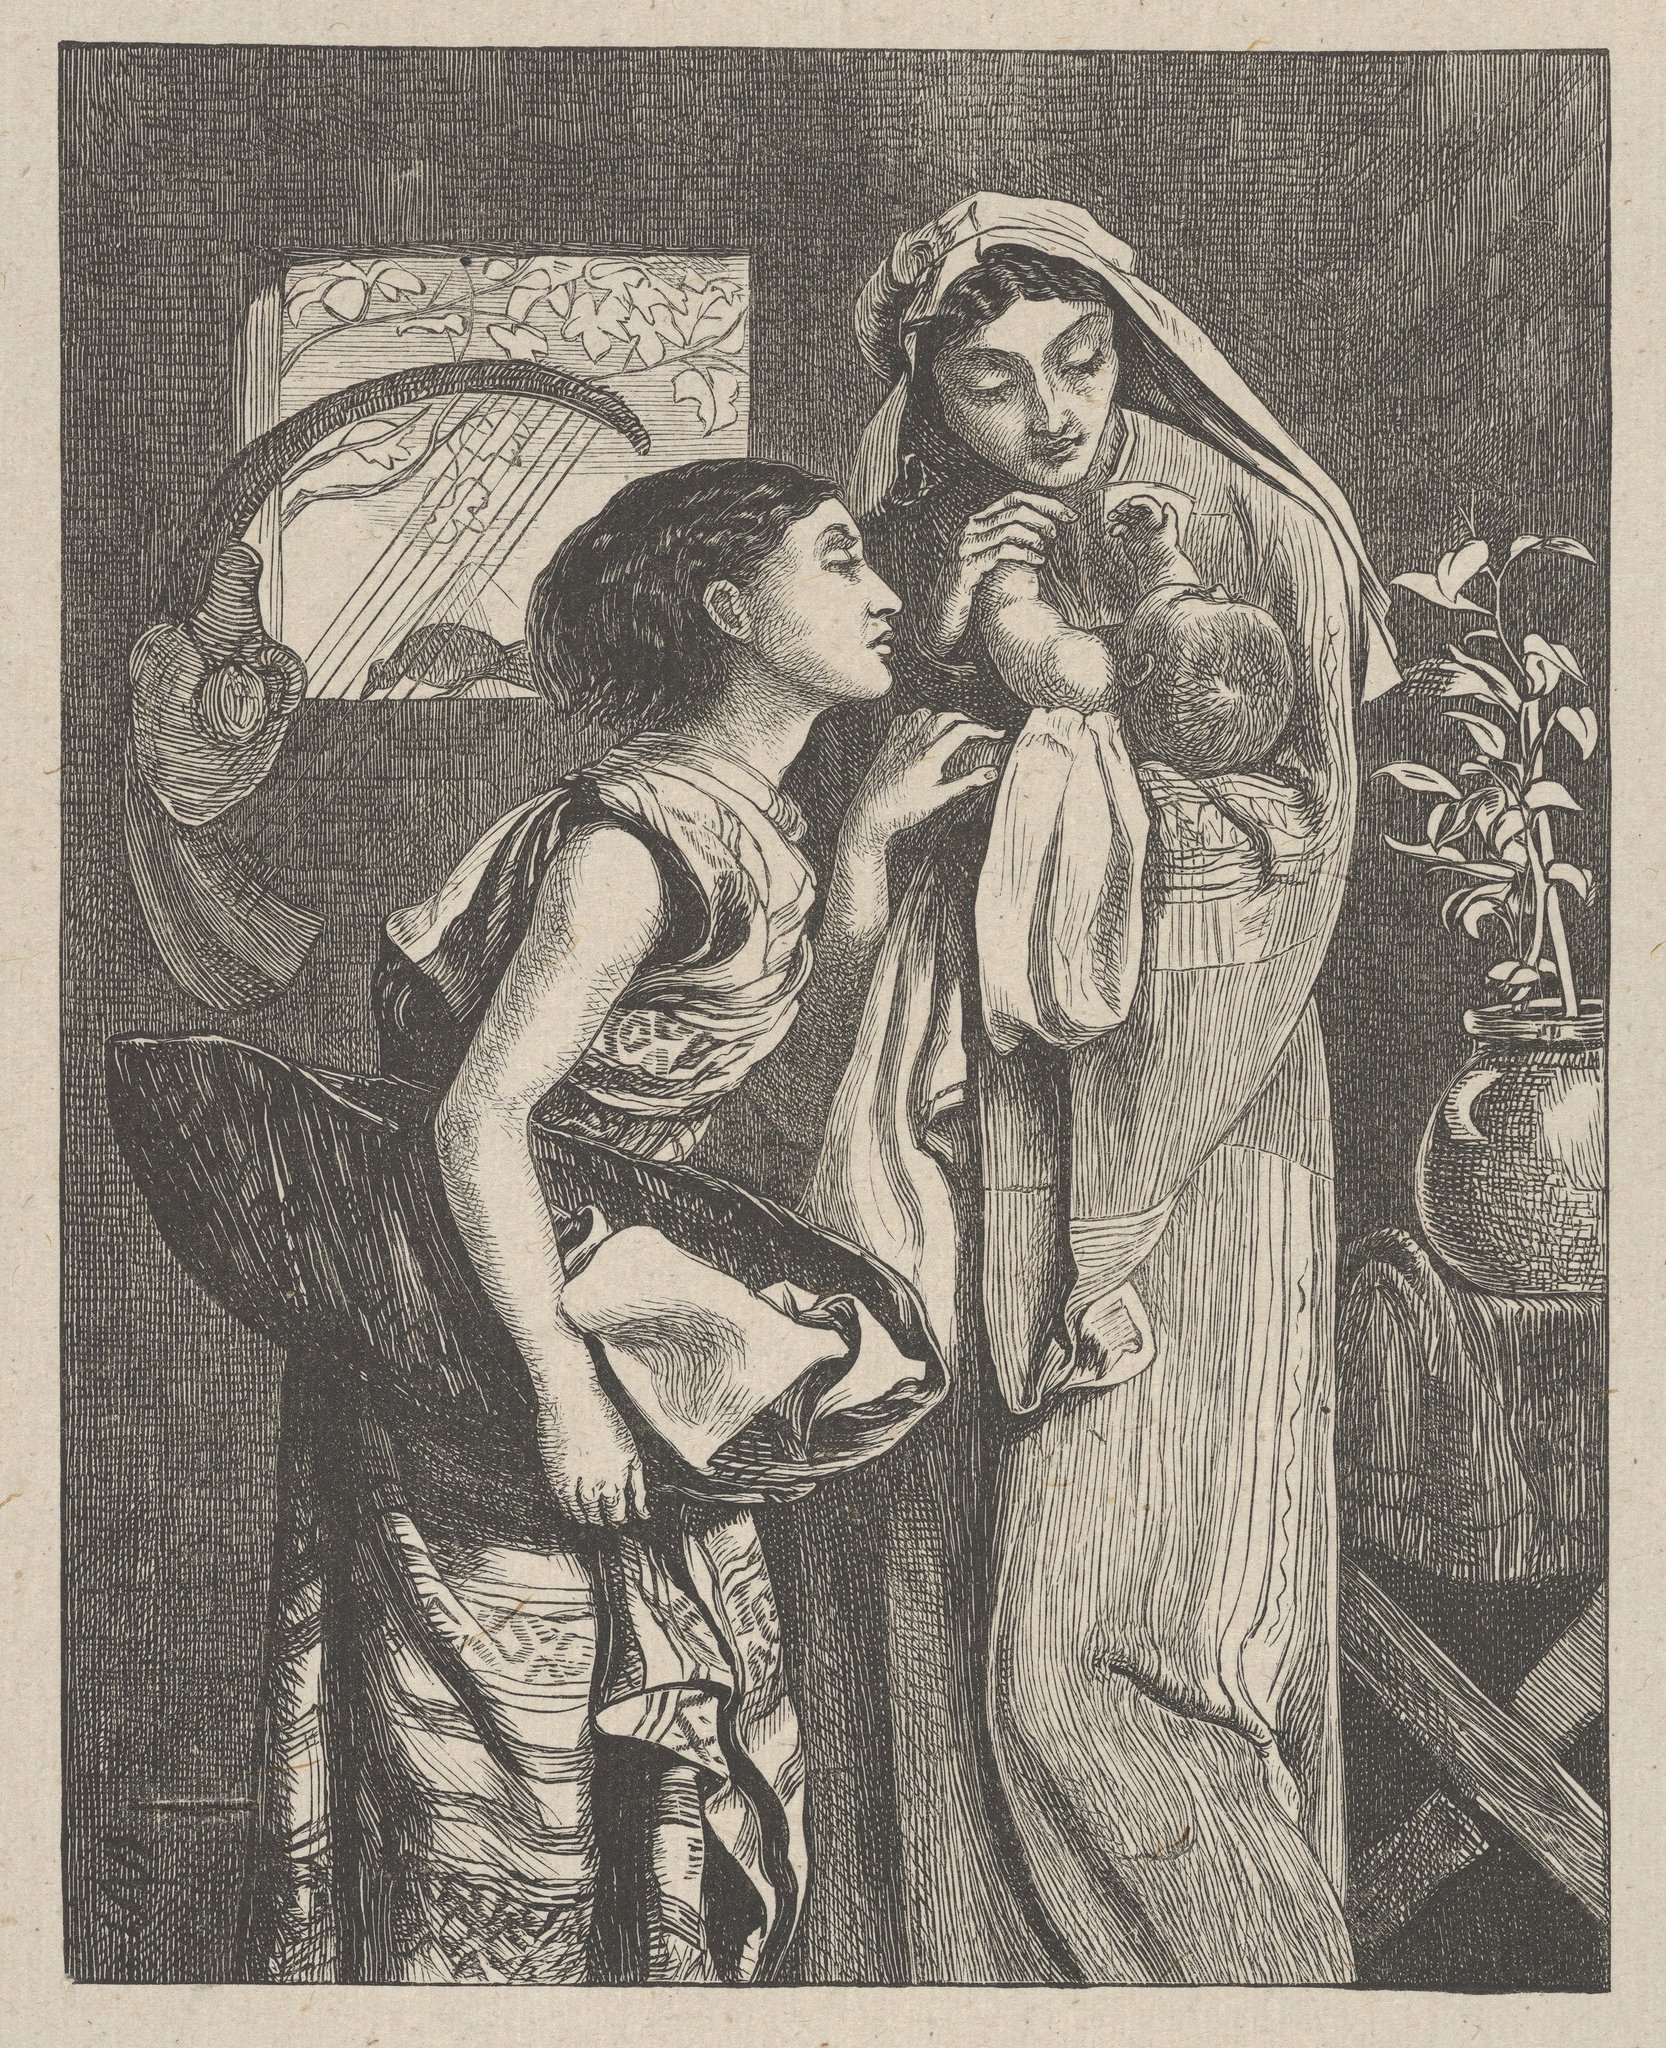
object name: print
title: The Infant Moses, from "Dalziels' Bible Gallery"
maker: simeon solomon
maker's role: artist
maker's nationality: british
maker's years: 1840-1905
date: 1863-1881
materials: paper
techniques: engraving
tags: girls,mothers,moses